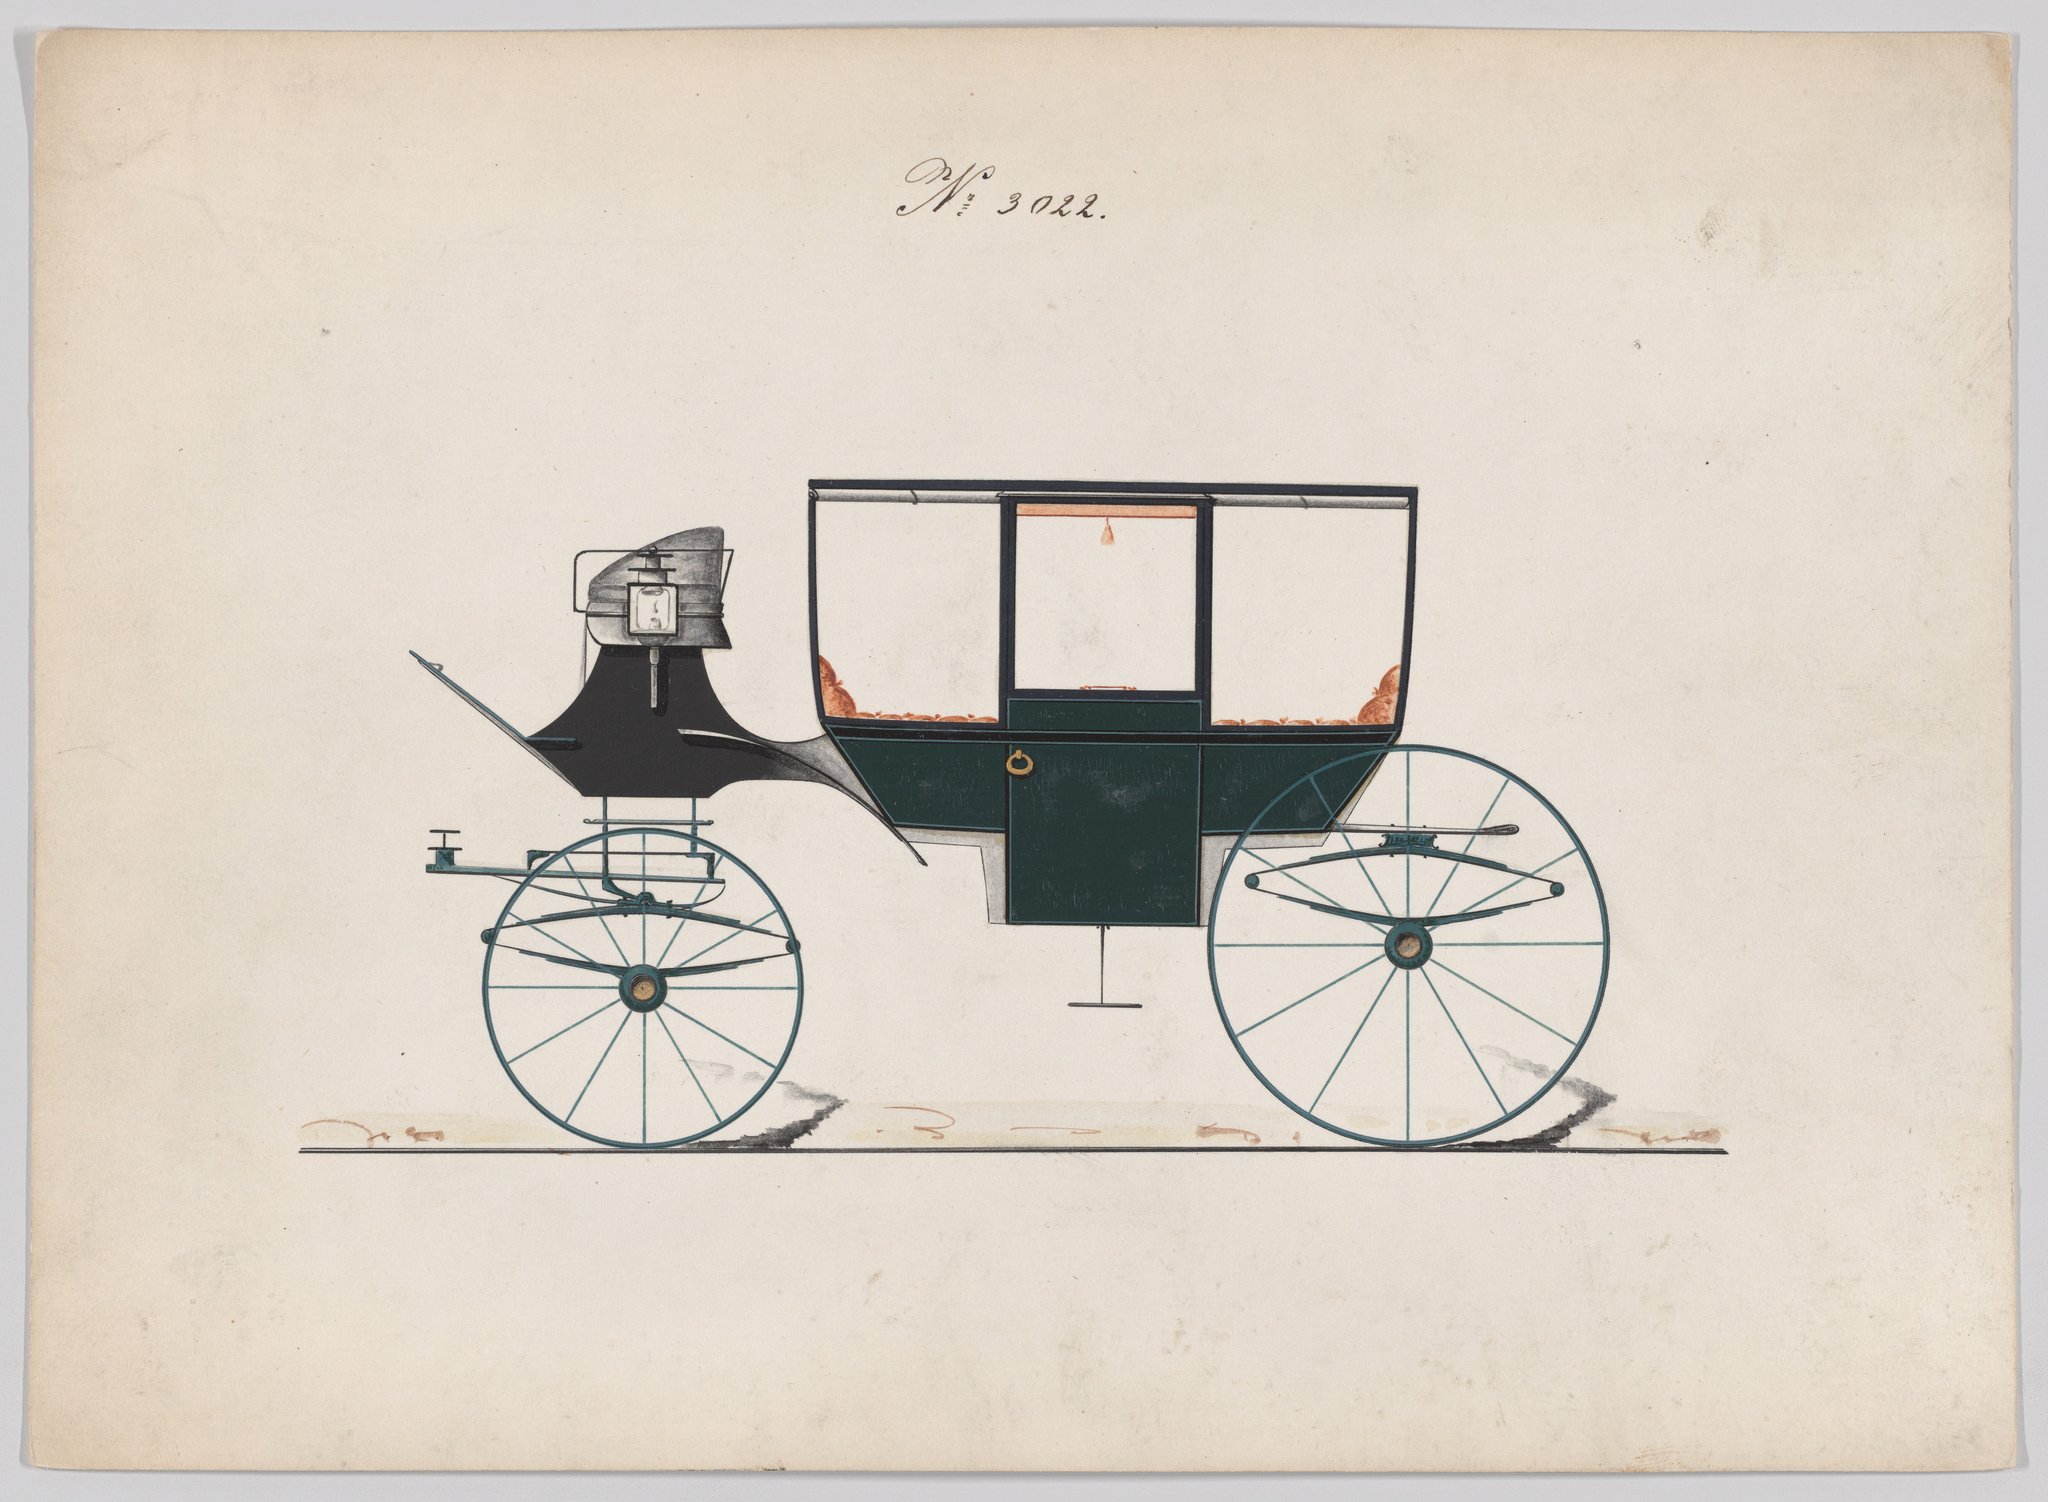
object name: drawing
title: Coach #3022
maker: brewster & co.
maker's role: manufacturer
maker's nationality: american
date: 1874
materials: gouache, gum arabic, ink, watercolor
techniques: pen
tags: carriages